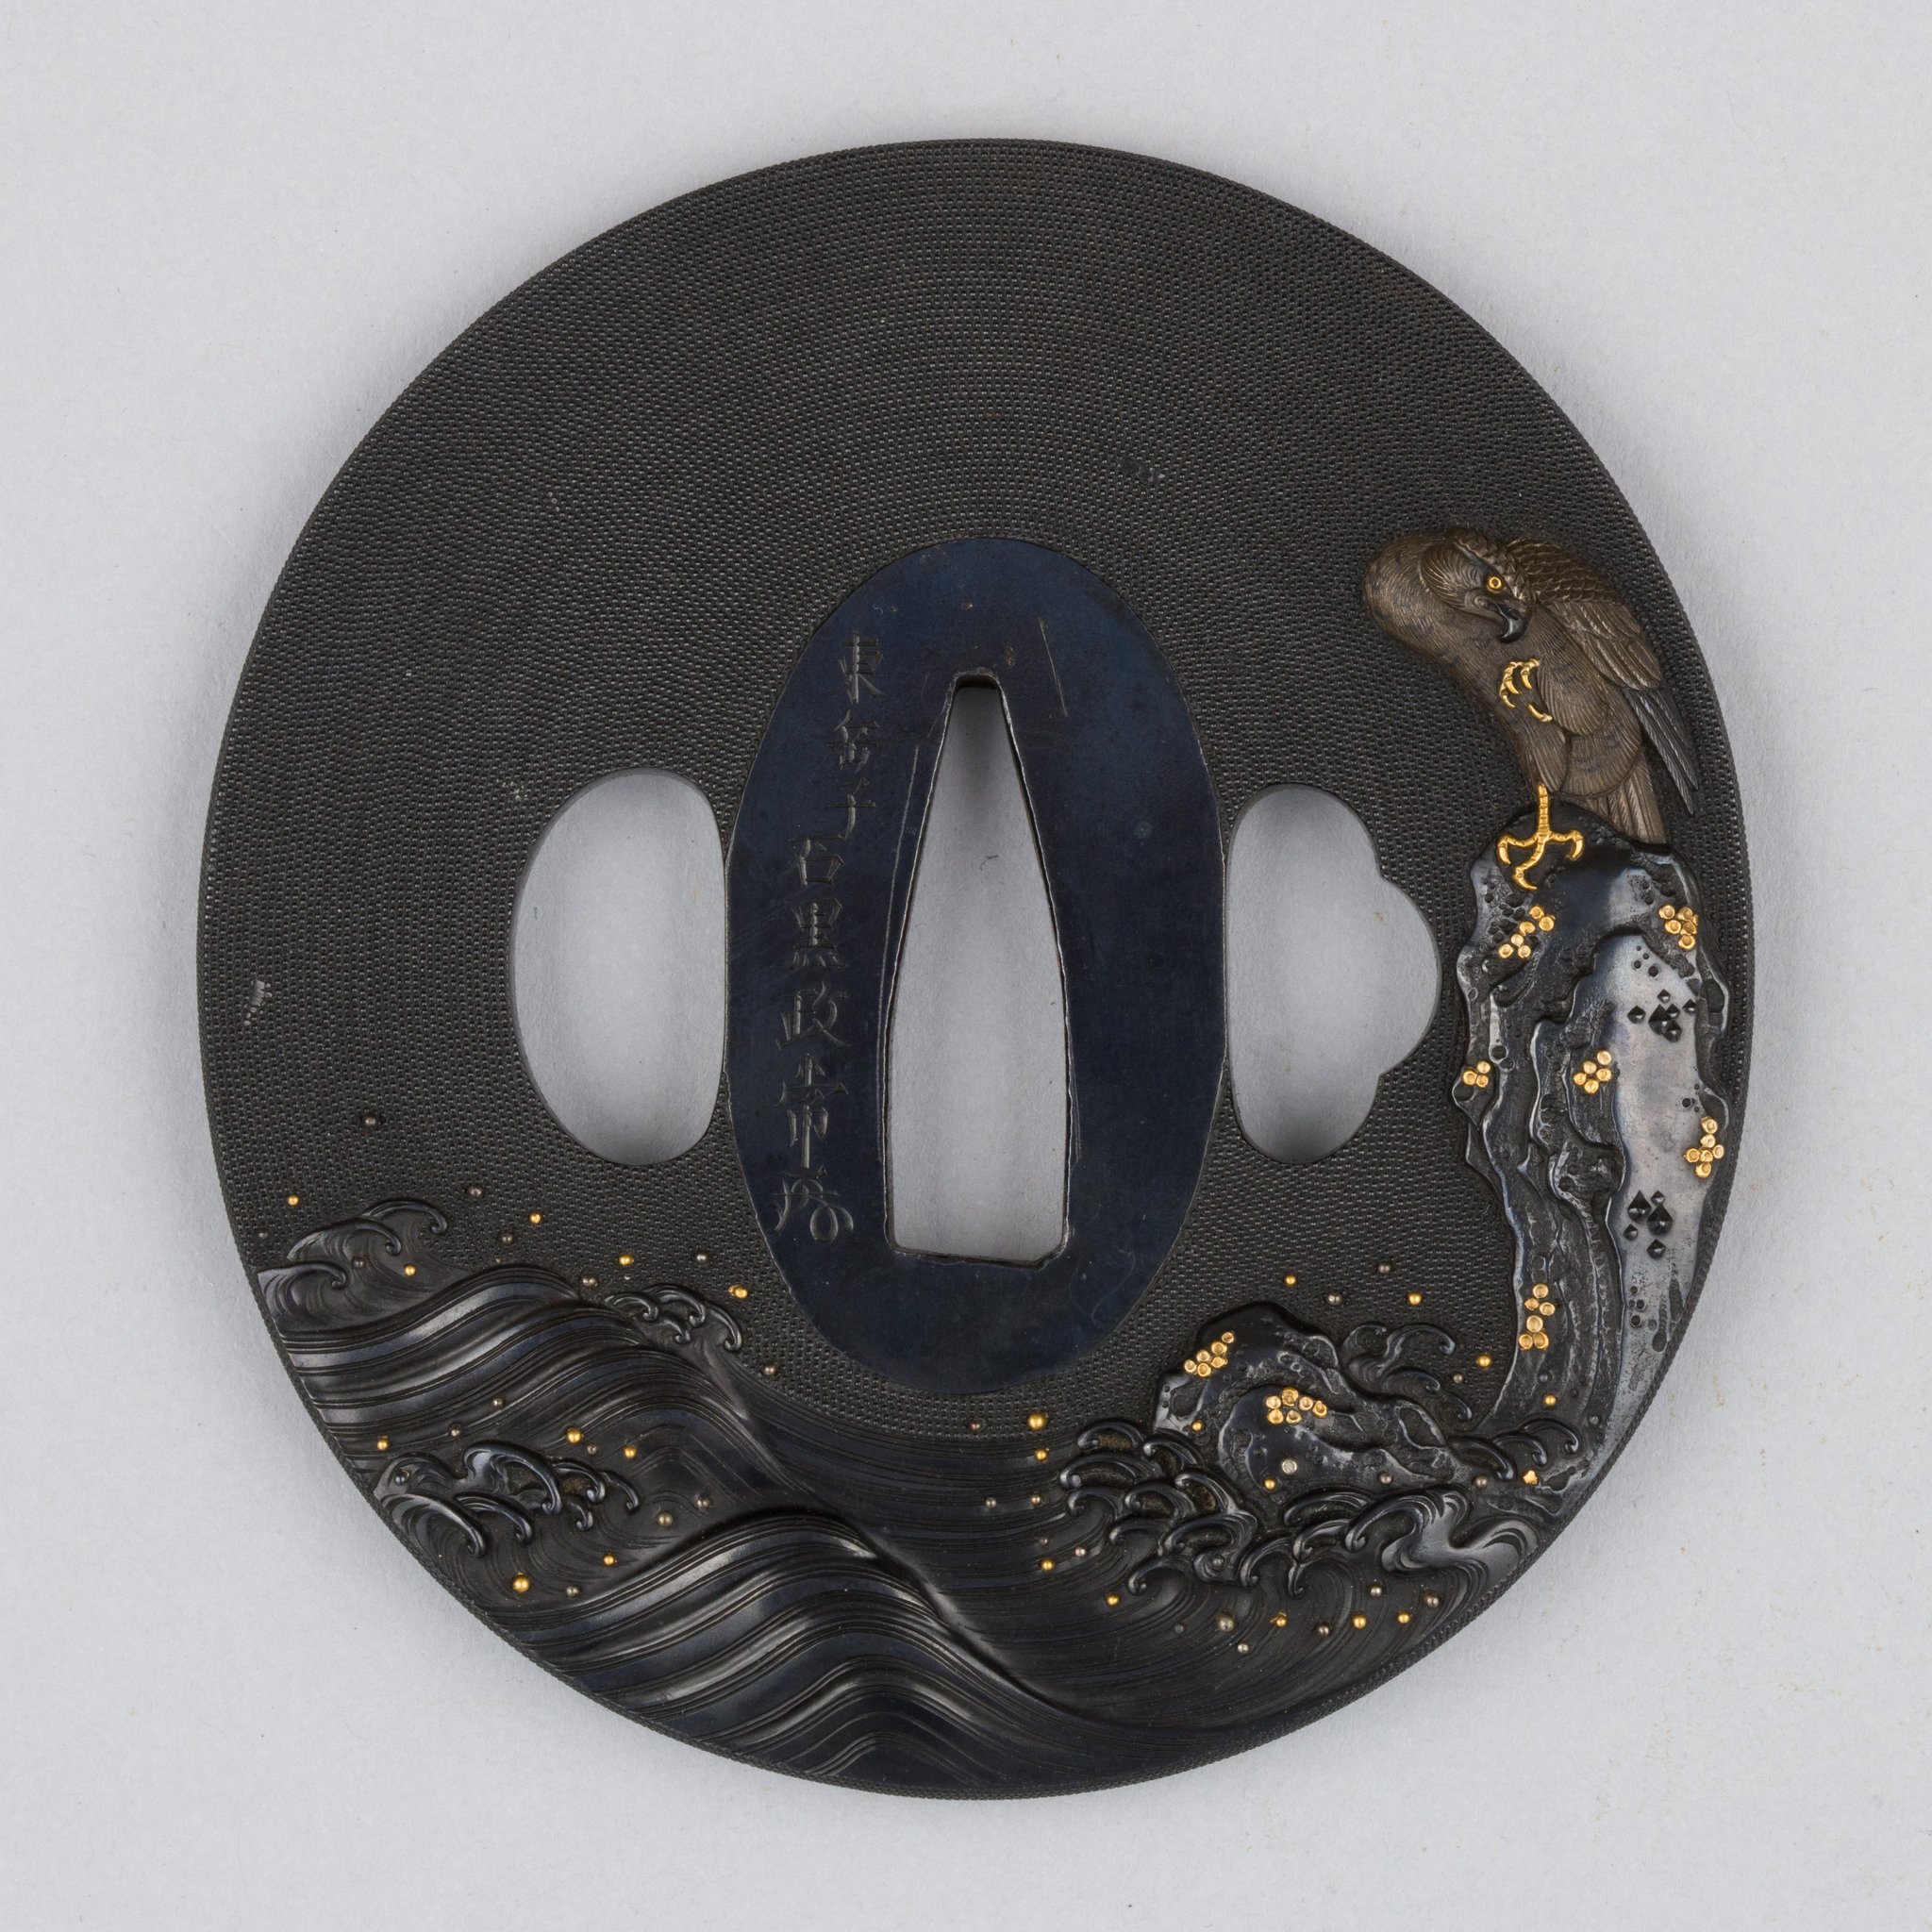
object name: pair of sword guard i daishō tsuba i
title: 波濤に岩上鷹図大小鐔 Matching Pair of Sword Guards (Daishō-tsuba)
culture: japanese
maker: 石黒政常 ishiguro masatsune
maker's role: fittings maker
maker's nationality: japanese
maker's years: 1760-1828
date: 1767-1833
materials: copper, gold alloy, silver alloy, gold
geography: japan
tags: eagles,waves